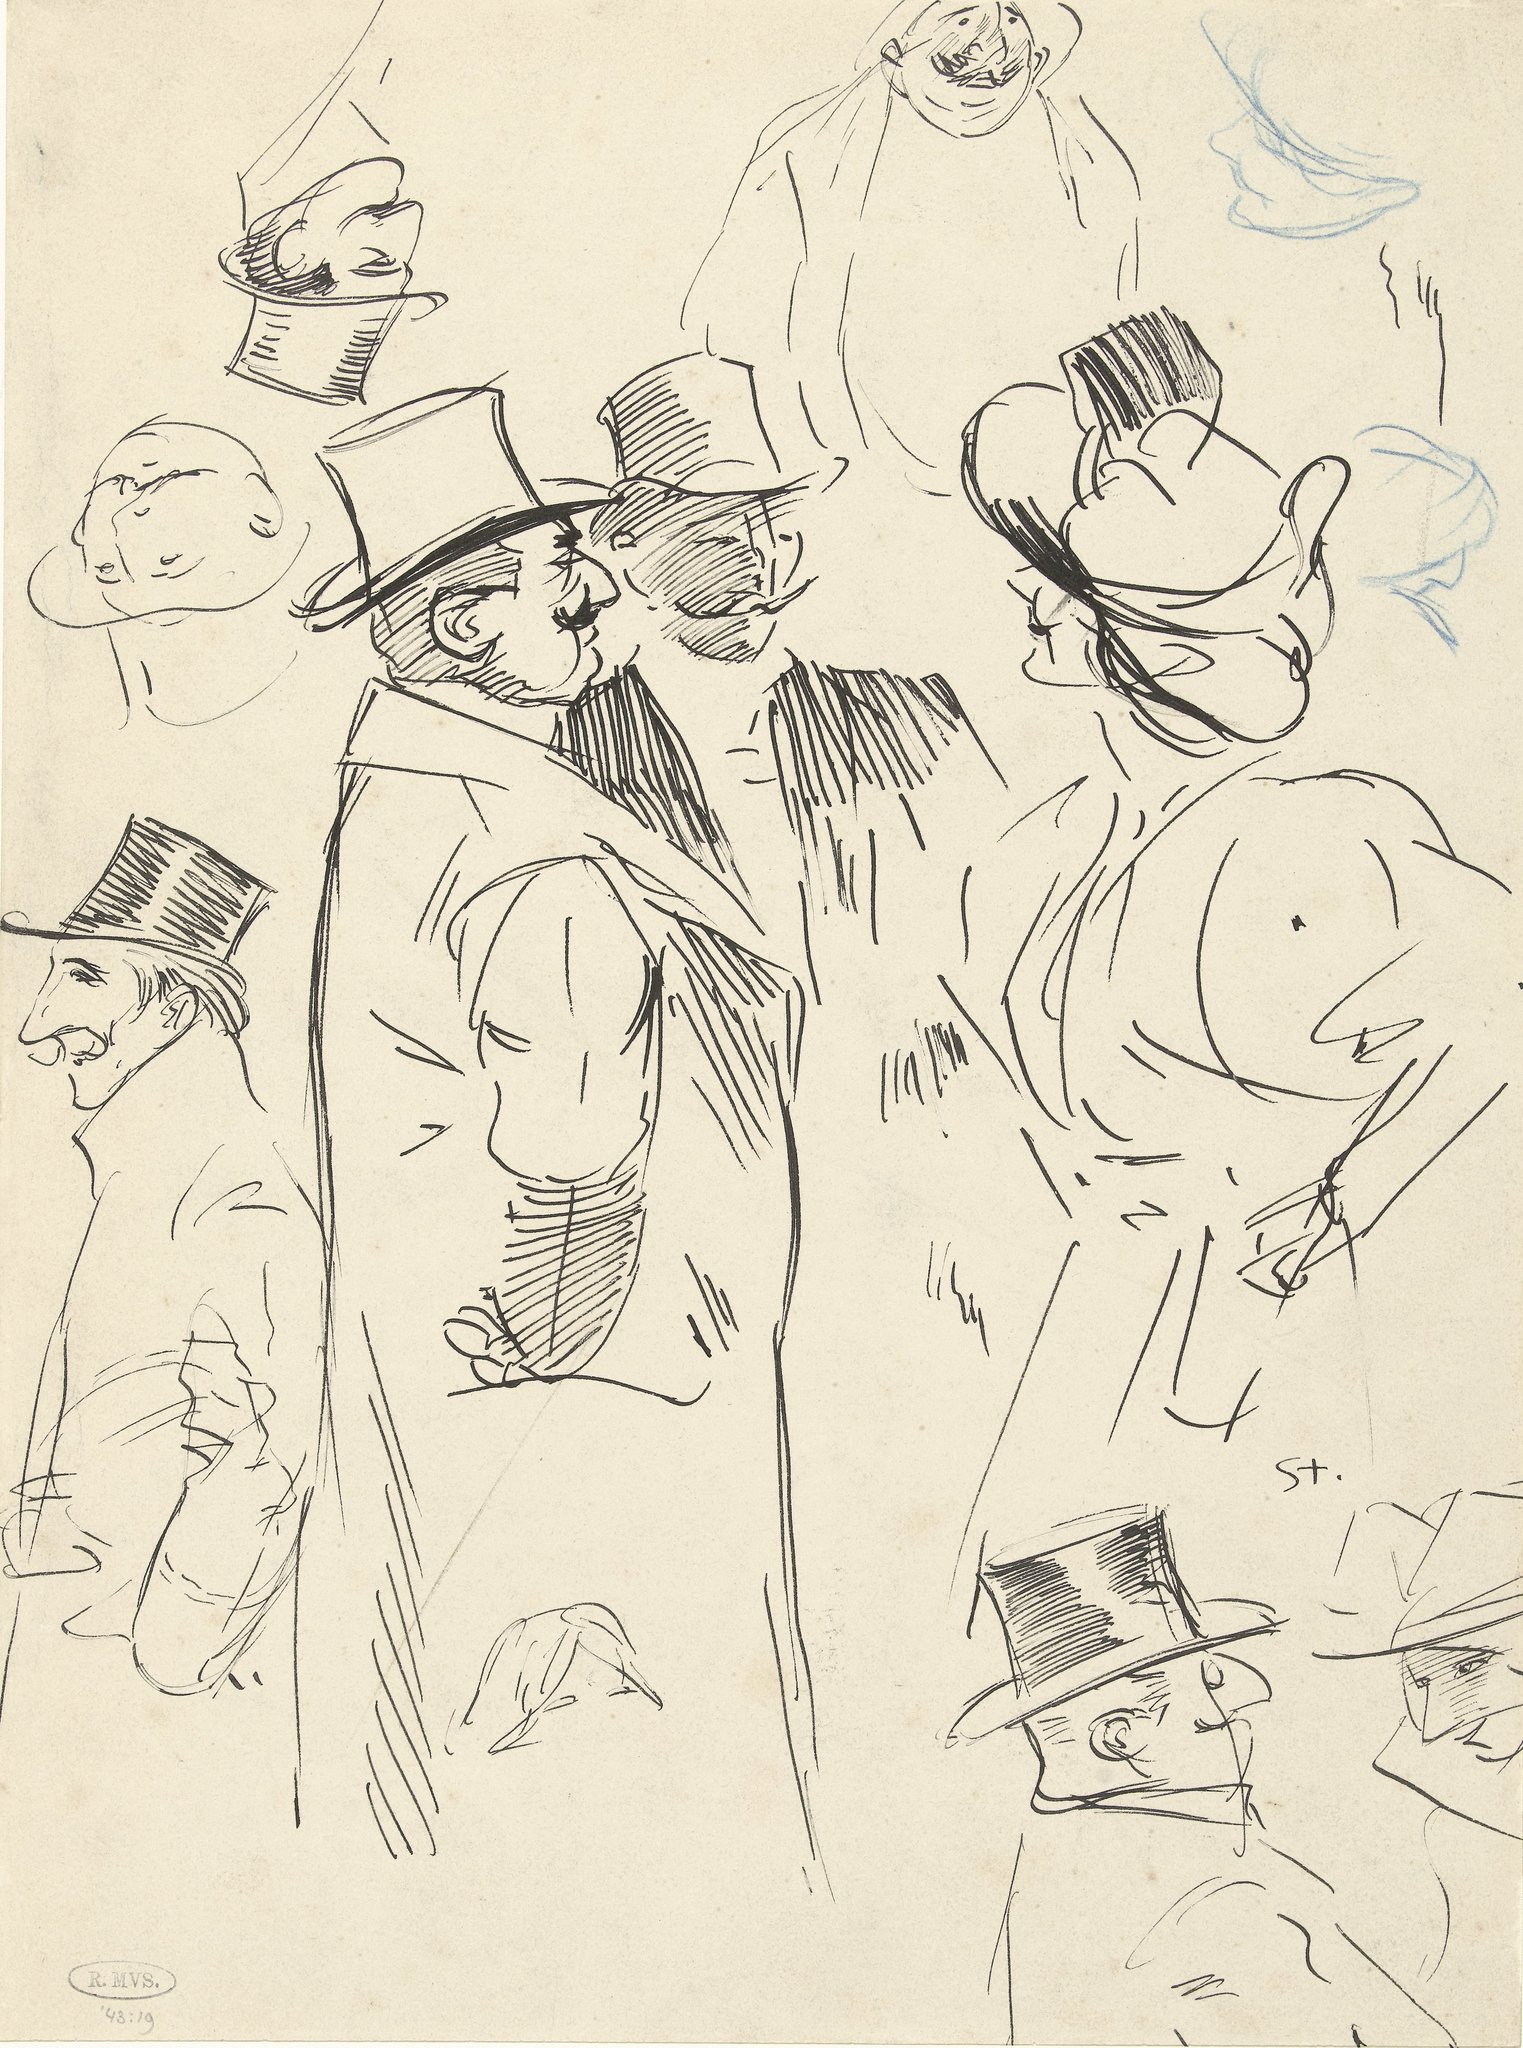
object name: drawing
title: Karikaturale portretstudies van twee heren en een vrouw in gesprek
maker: théophile alexandre steinlen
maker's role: draughtsman, painter, print maker, sculptor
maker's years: 1859-1923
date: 1869-1923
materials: chalk, ink, paper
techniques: pen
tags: standing figure, caricatures (human types), standing figure - aa - female human figure